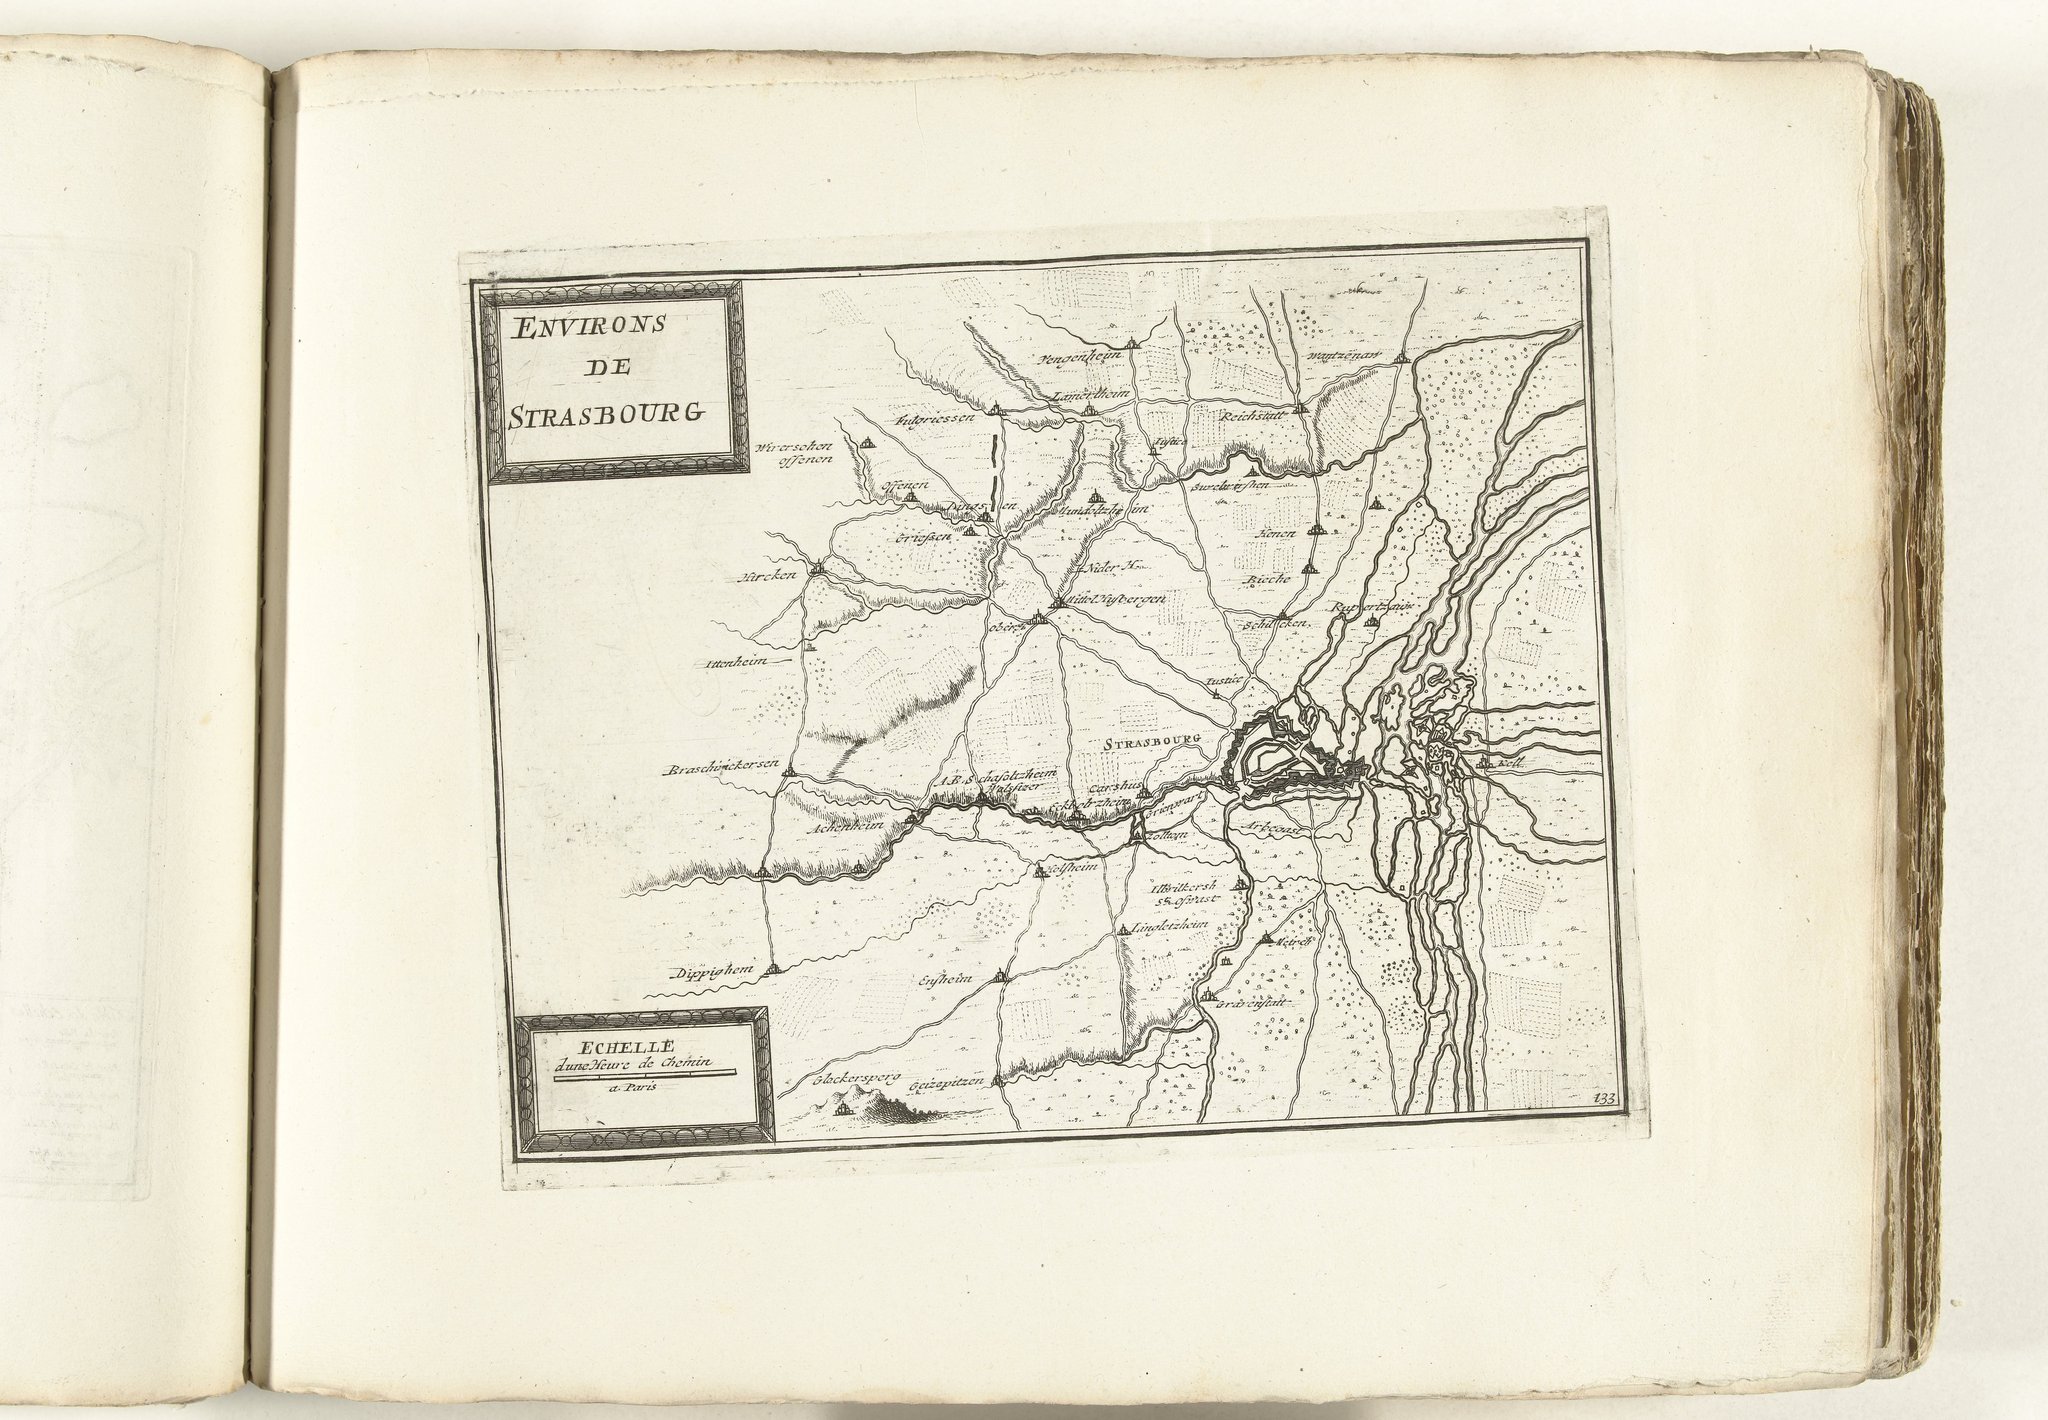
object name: map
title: Les Forces de l'Europe, Asie, Afrique et Amerique, ou description des principales villes avec leurs fortifications. Dessignées par les meilleurs ingenieurs, particulierement celles qui sont sous la domination de la France (...) et ornées de plusieurs superbes edifices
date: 1702-1703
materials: paper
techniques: etching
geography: northern netherlands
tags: maps of separate countries or regions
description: Kaart van de Franse stad Straatsburg en omgeving. Plaat nr. 133 in het prentwerk bestaande in totaal uit 276 genummerde platen van vermaarde sterke steden en vestingen in het kader van de Spaanse Successieoorlog. Voor het merendeel zijn deze platen gekopieerd naar de anonieme Franse platen: in Les forces de l'Europe en in: Le theatre de la guerre, dans les Pays-Bas, beide oorspronkelijk uitgegeven door Nicolas de Fer te Parijs (1693-1697) in het kader van de Negenjarige Oorlog. Titel en opschriften in de plaat in het Frans.